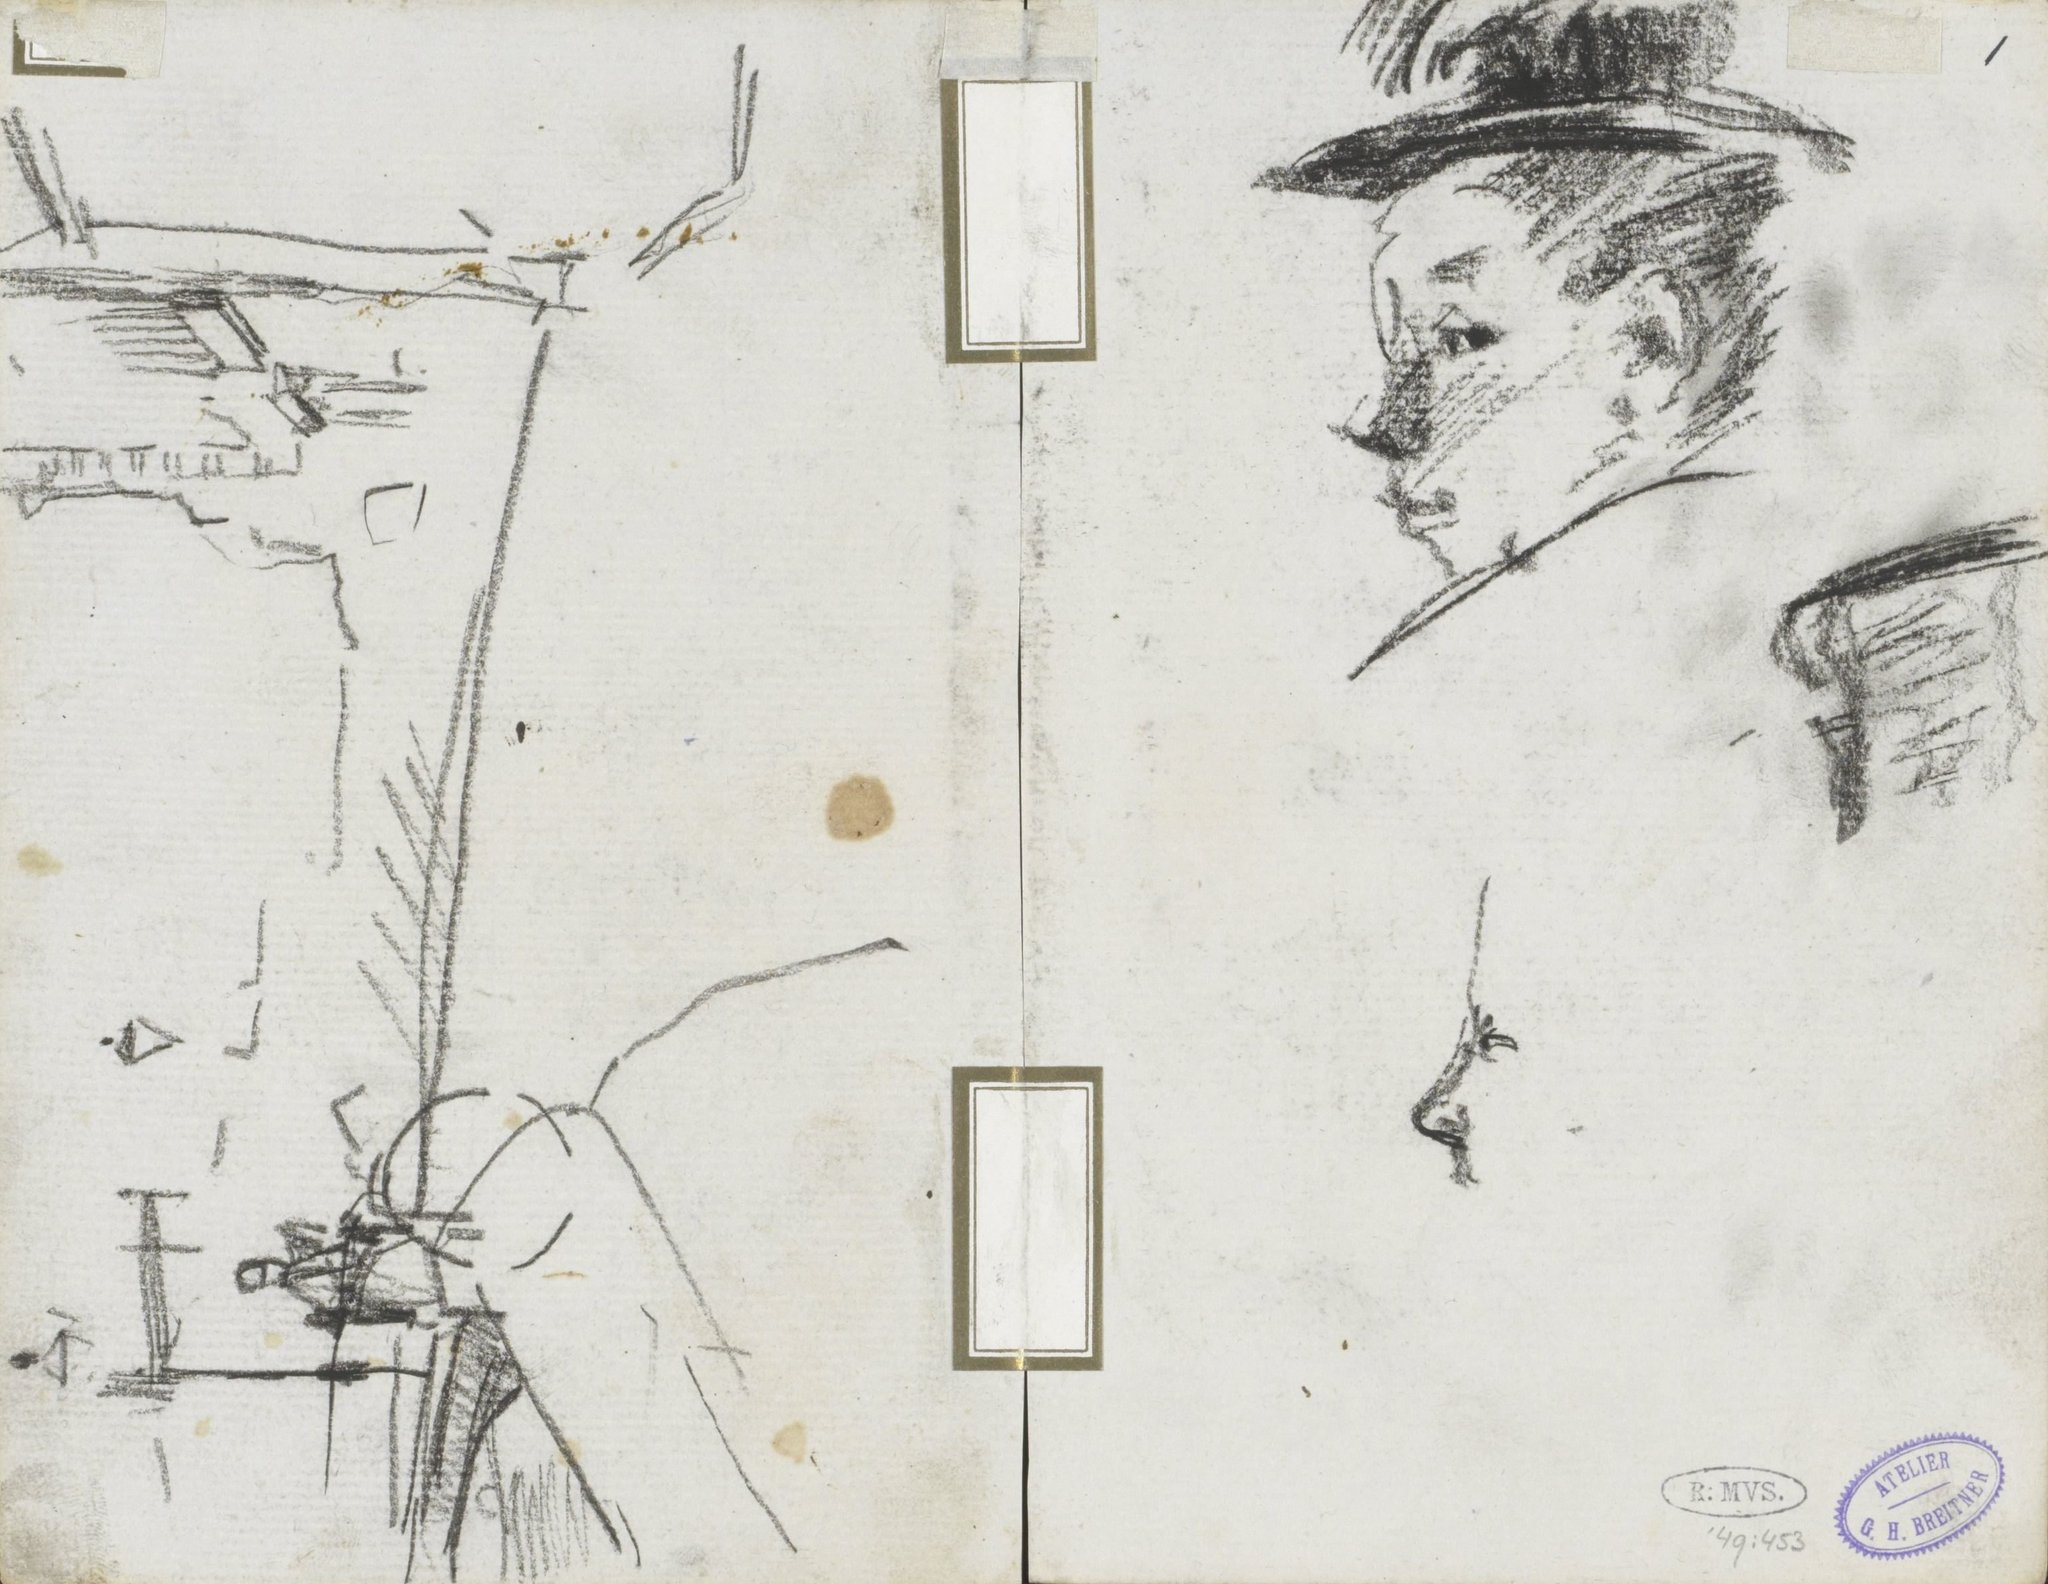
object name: drawing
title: Gezicht in Amsterdam en studies van een hoofd met hoed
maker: george hendrik breitner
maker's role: draughtsman, painter, print maker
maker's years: 1857-1923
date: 1909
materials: chalk, paper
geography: amsterdam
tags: urban housing, head (human), head-gear: hat (+ men's clothes), canals, waters (in city)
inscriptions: workshop stamp: Lugt 291d, collector's mark: Lugt 2228